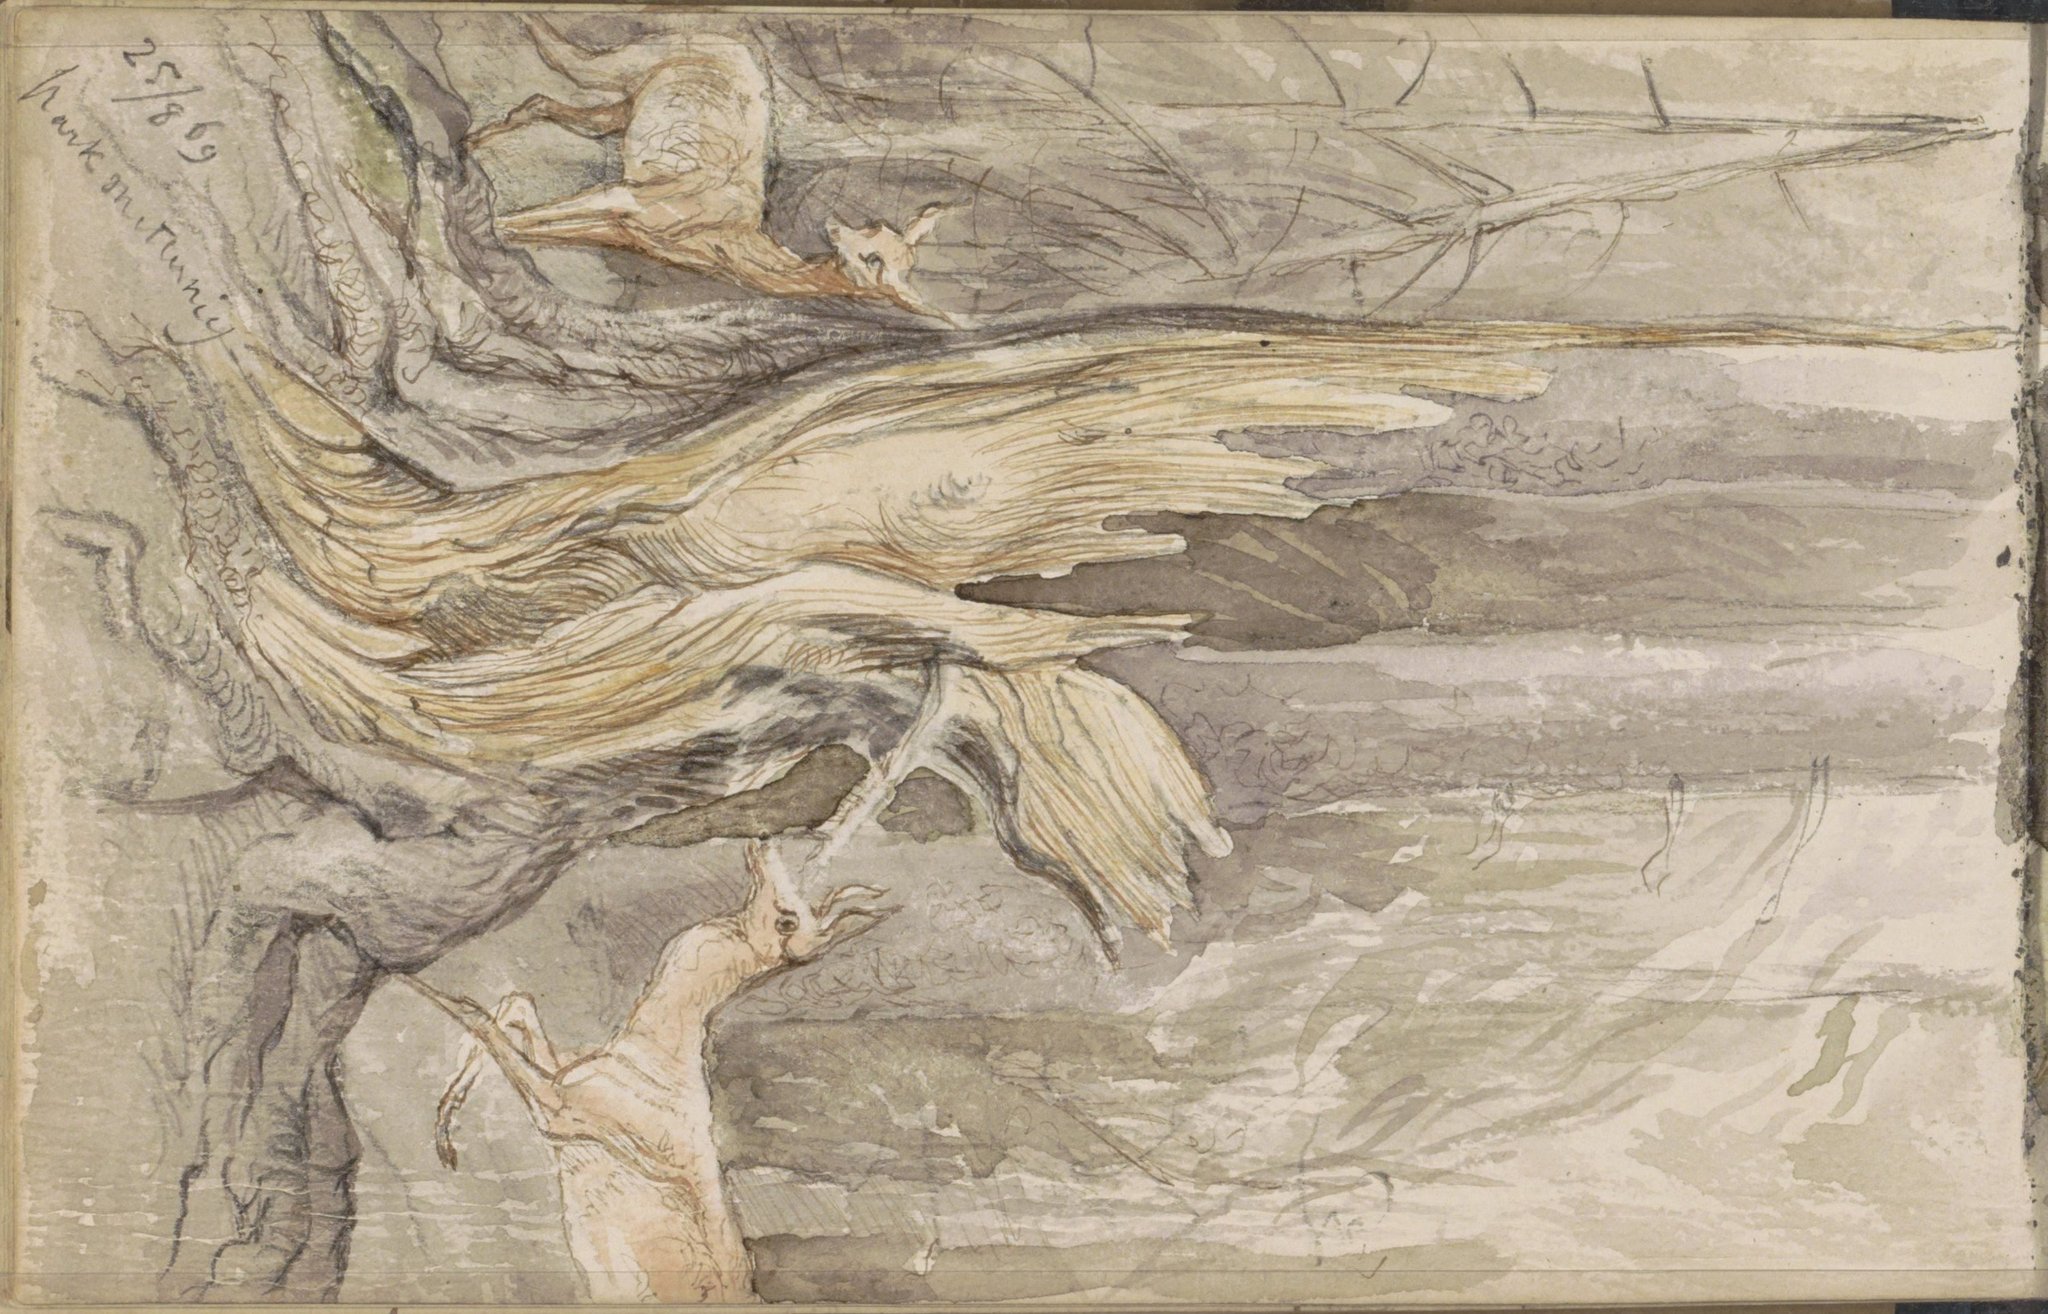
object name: sketchbook leaf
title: Reeën bij een gespleten boomstam in het park van Metternich bij Marienbad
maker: johannes tavenraat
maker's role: draughtsman, painter, print maker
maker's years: 1809-1881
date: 1808-1869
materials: ink, paper, pencil, watercolor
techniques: brush, pen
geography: marienbad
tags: trees, hoofed animals: deer, forest, wood, marienbad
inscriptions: date and inscription: ‘25/8 69/ park Metternic[...]’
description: Blad 29 verso uit een schetsboek met 48 bladen.